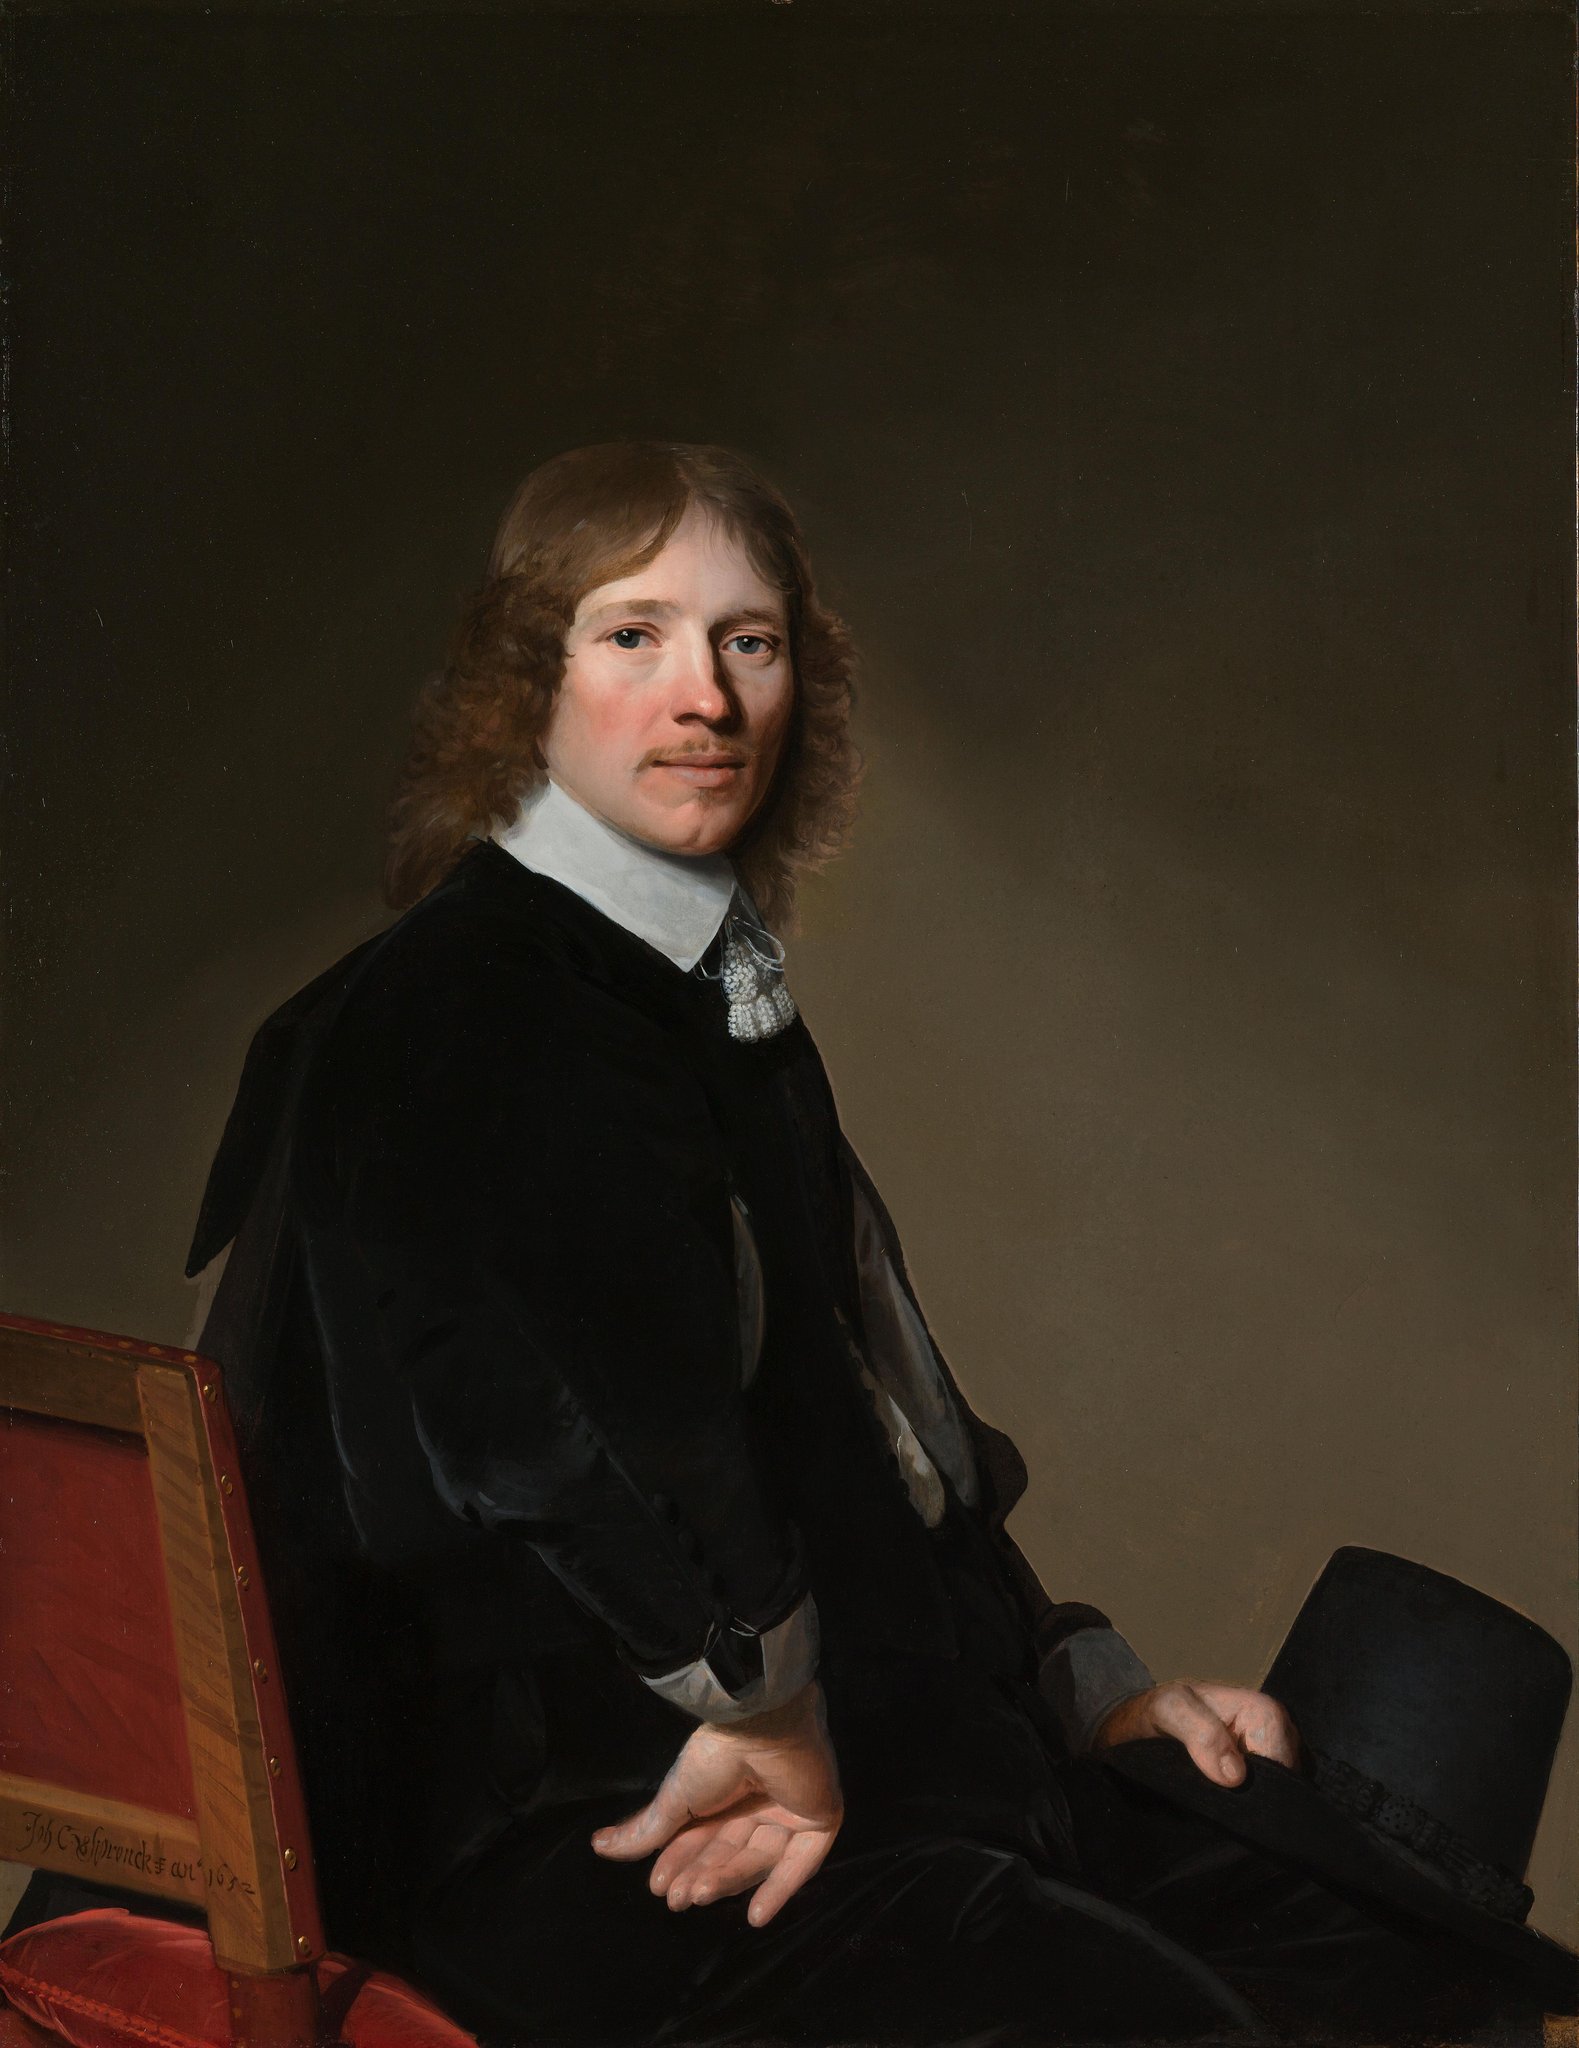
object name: painting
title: Portrait of Eduard Wallis (1621-1684)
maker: johannes verspronck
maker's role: painter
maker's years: 1600-1662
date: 1652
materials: oil, paint, panel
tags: historical persons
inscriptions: signature and date, lower left, on the back of the chair (‘ver’ ligated): ‘Joh C. verSpronck f an° 1652’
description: The Haarlem textile merchant Eduard Wallis presents himself with one arm akimbo, a fashionable pose that was the epitome of self-assurance. Here he wears his own merchandise, very costly black-dyed cloth, the high-quality woollen fabric of the time. Wallis was married to Maria van Strijp, who also hailed from a well-to-do textile family. With their union, they consolidated their standing in the Haarlem cloth trade.